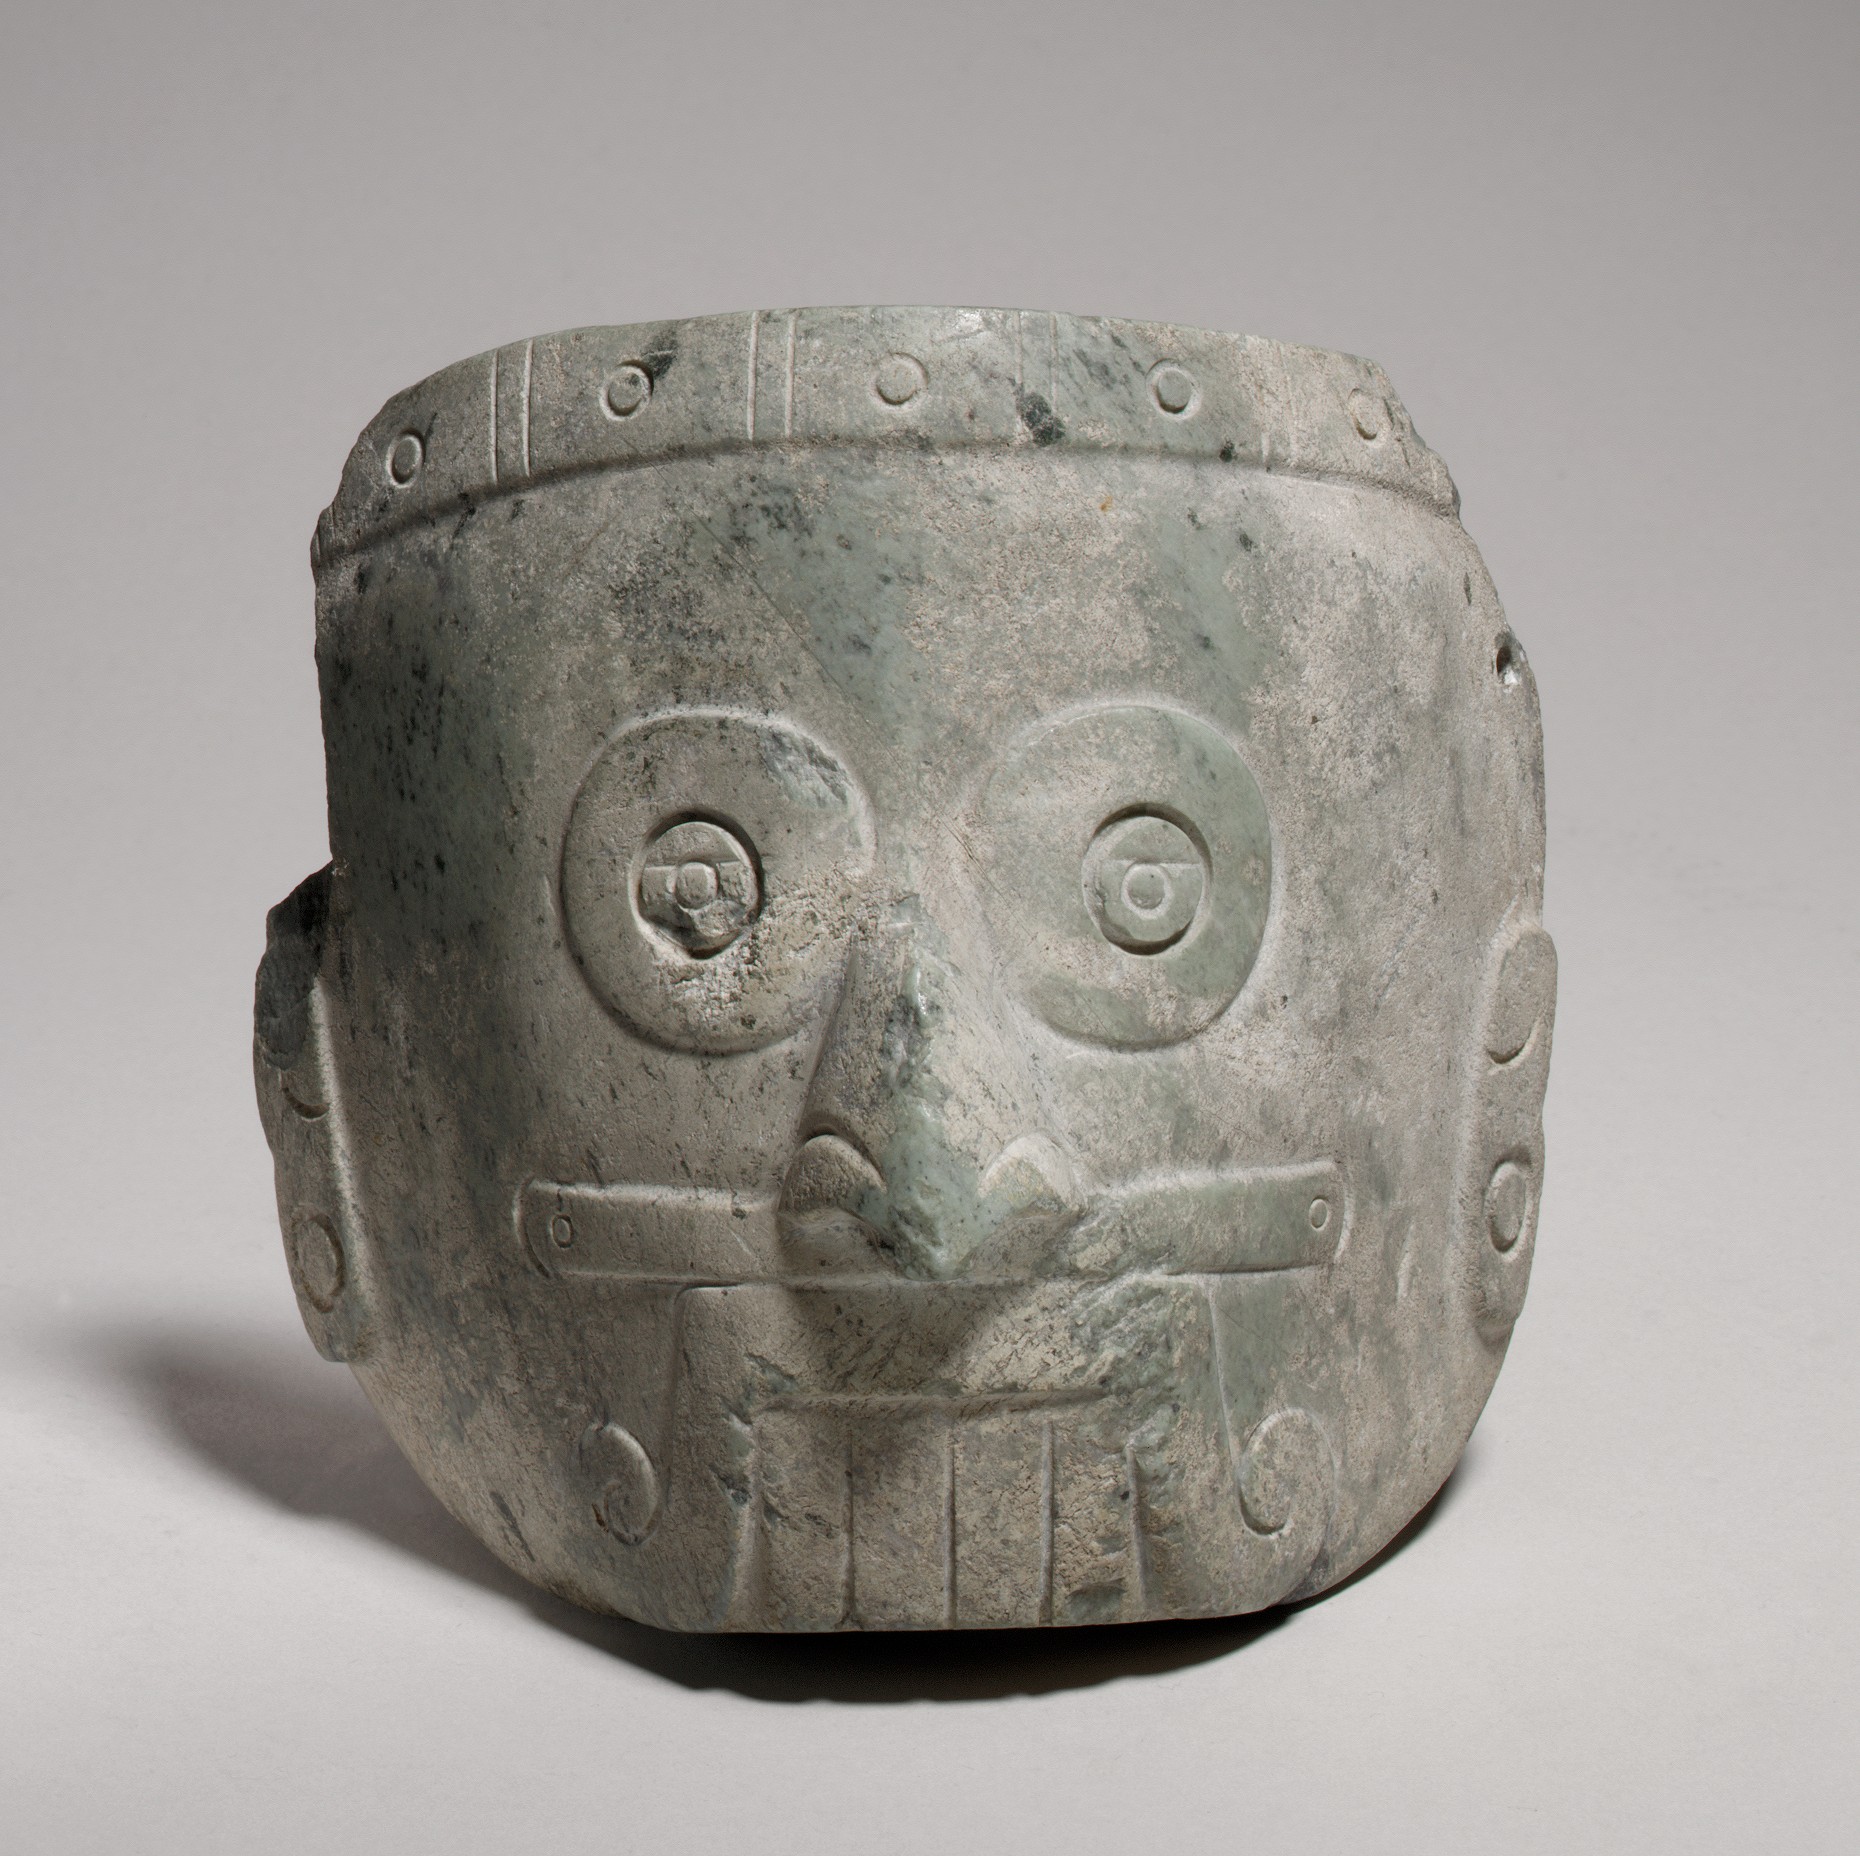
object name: mask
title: Rain god mask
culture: mixtec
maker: mixtec (ñuu savi) artist(s)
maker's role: artist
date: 1325-1521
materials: stone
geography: mexico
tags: faces